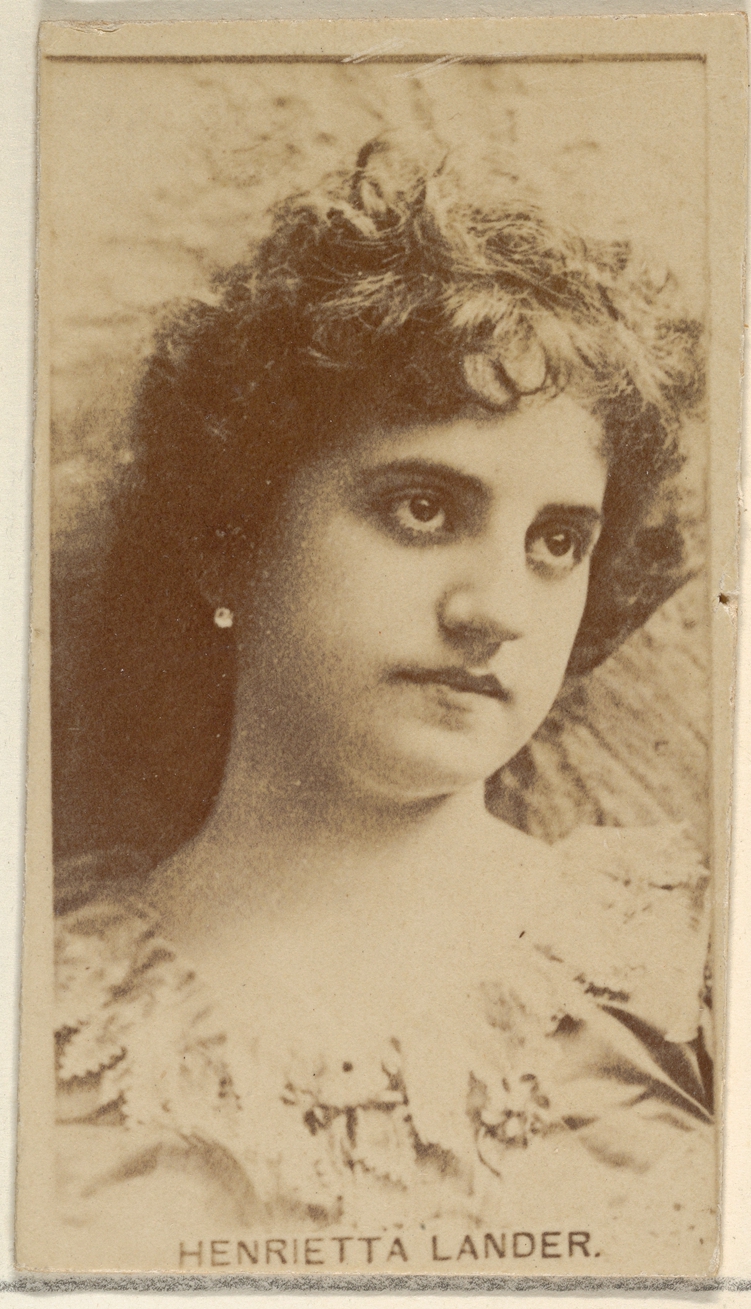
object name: photograph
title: Henrietta Lander, from the Actors and Actresses series (N45, Type 8) for Virginia Brights Cigarettes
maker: allen & ginter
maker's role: publisher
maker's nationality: american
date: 1888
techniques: albumen silver print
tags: portraits,women,actresses